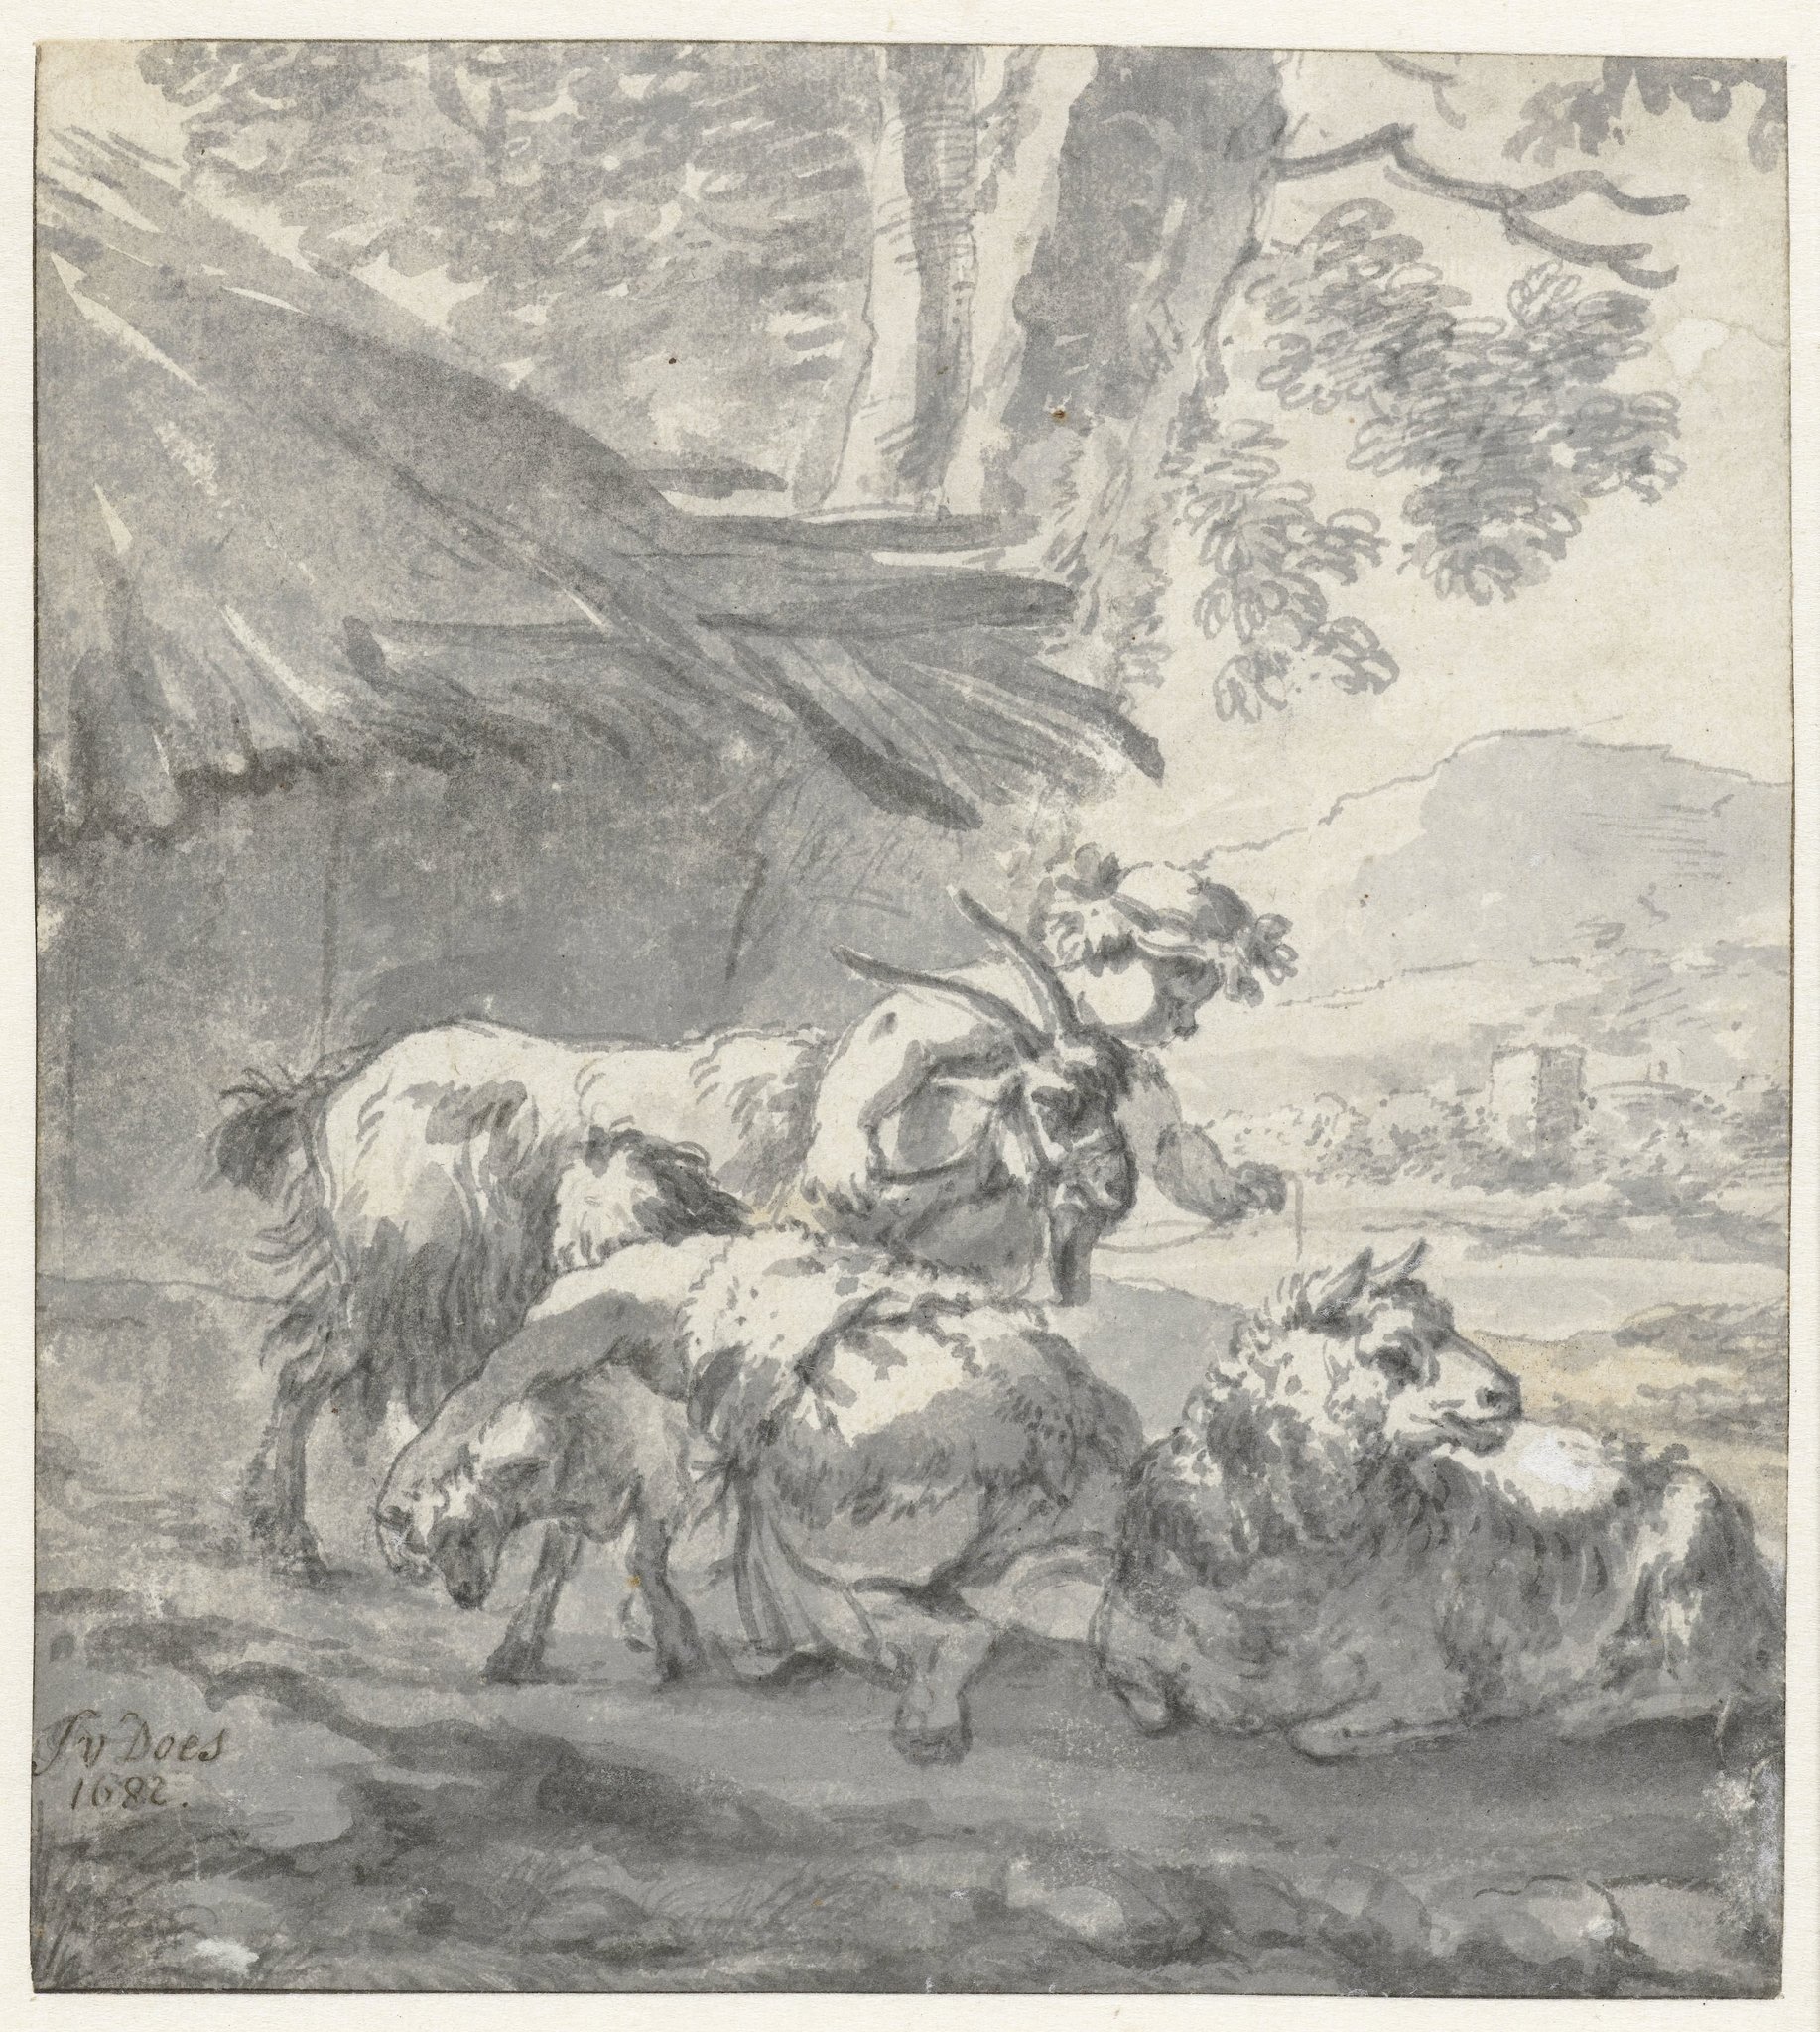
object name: drawing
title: Landscape with Two Children Playing with a Goat, a Lamb and a Sheep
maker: simon van der does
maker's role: draughtsman, painter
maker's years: 1653-1763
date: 1682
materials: chalk, ink, paper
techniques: brush, pen